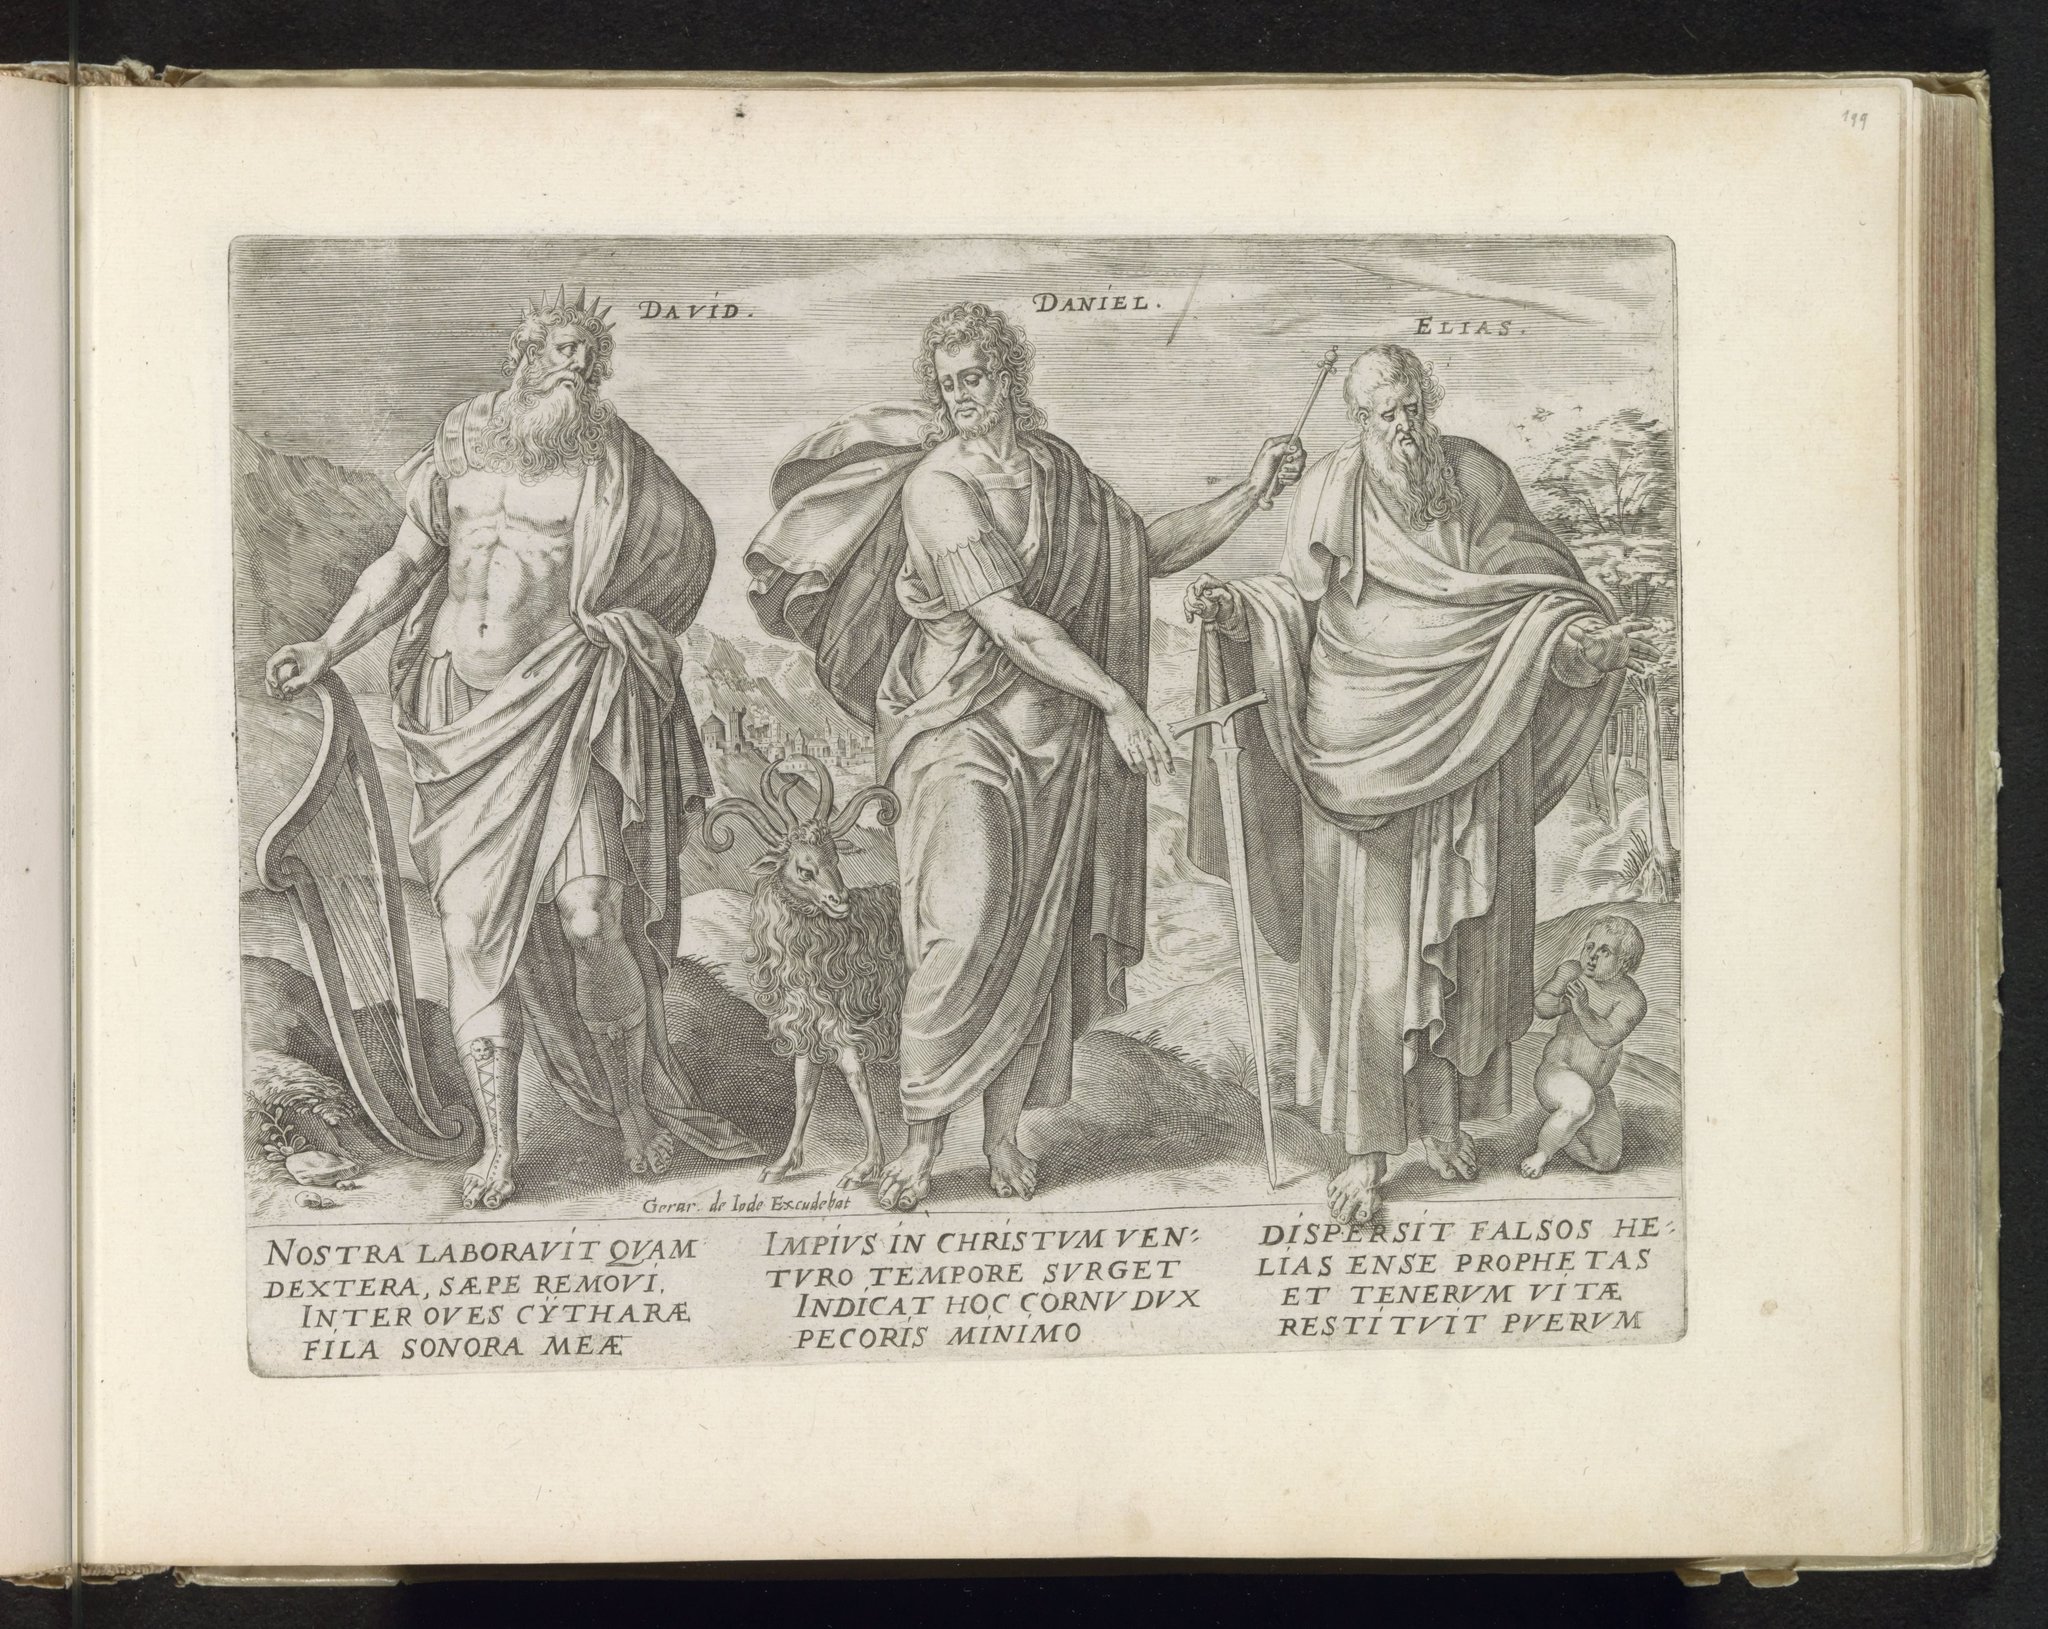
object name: album leaf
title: Twaalf profeten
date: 1585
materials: paper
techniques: engraving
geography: antwerp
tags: daniel (not in biblical context); possible attributes: phrygian bonnet, lion(s), ram - other activities, relationships, etc. of male persons from the old testament, david as prophet, with crown and scroll, groups of prophets, usually holding books or scrolls (isaiah, jeremiah, ezekiel, daniel, hosea, joel, amos, obadiah, jonah, micah, nahum, habakkuk, zephaniah, haggai, zechariah, malachi), elijah (not in biblical context); possible attributes: scroll and flaming sword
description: De profeten David, Daniël en Elia staan naast elkaar in een landschap. Koning David met kroon en harp, Daniël met staf en naast hem een bok, Elia met zwaard en een knielend kind naast zich. Onder de voorstelling toelichtingen in het Latijn. Deze prent maakt deel uit van een album.